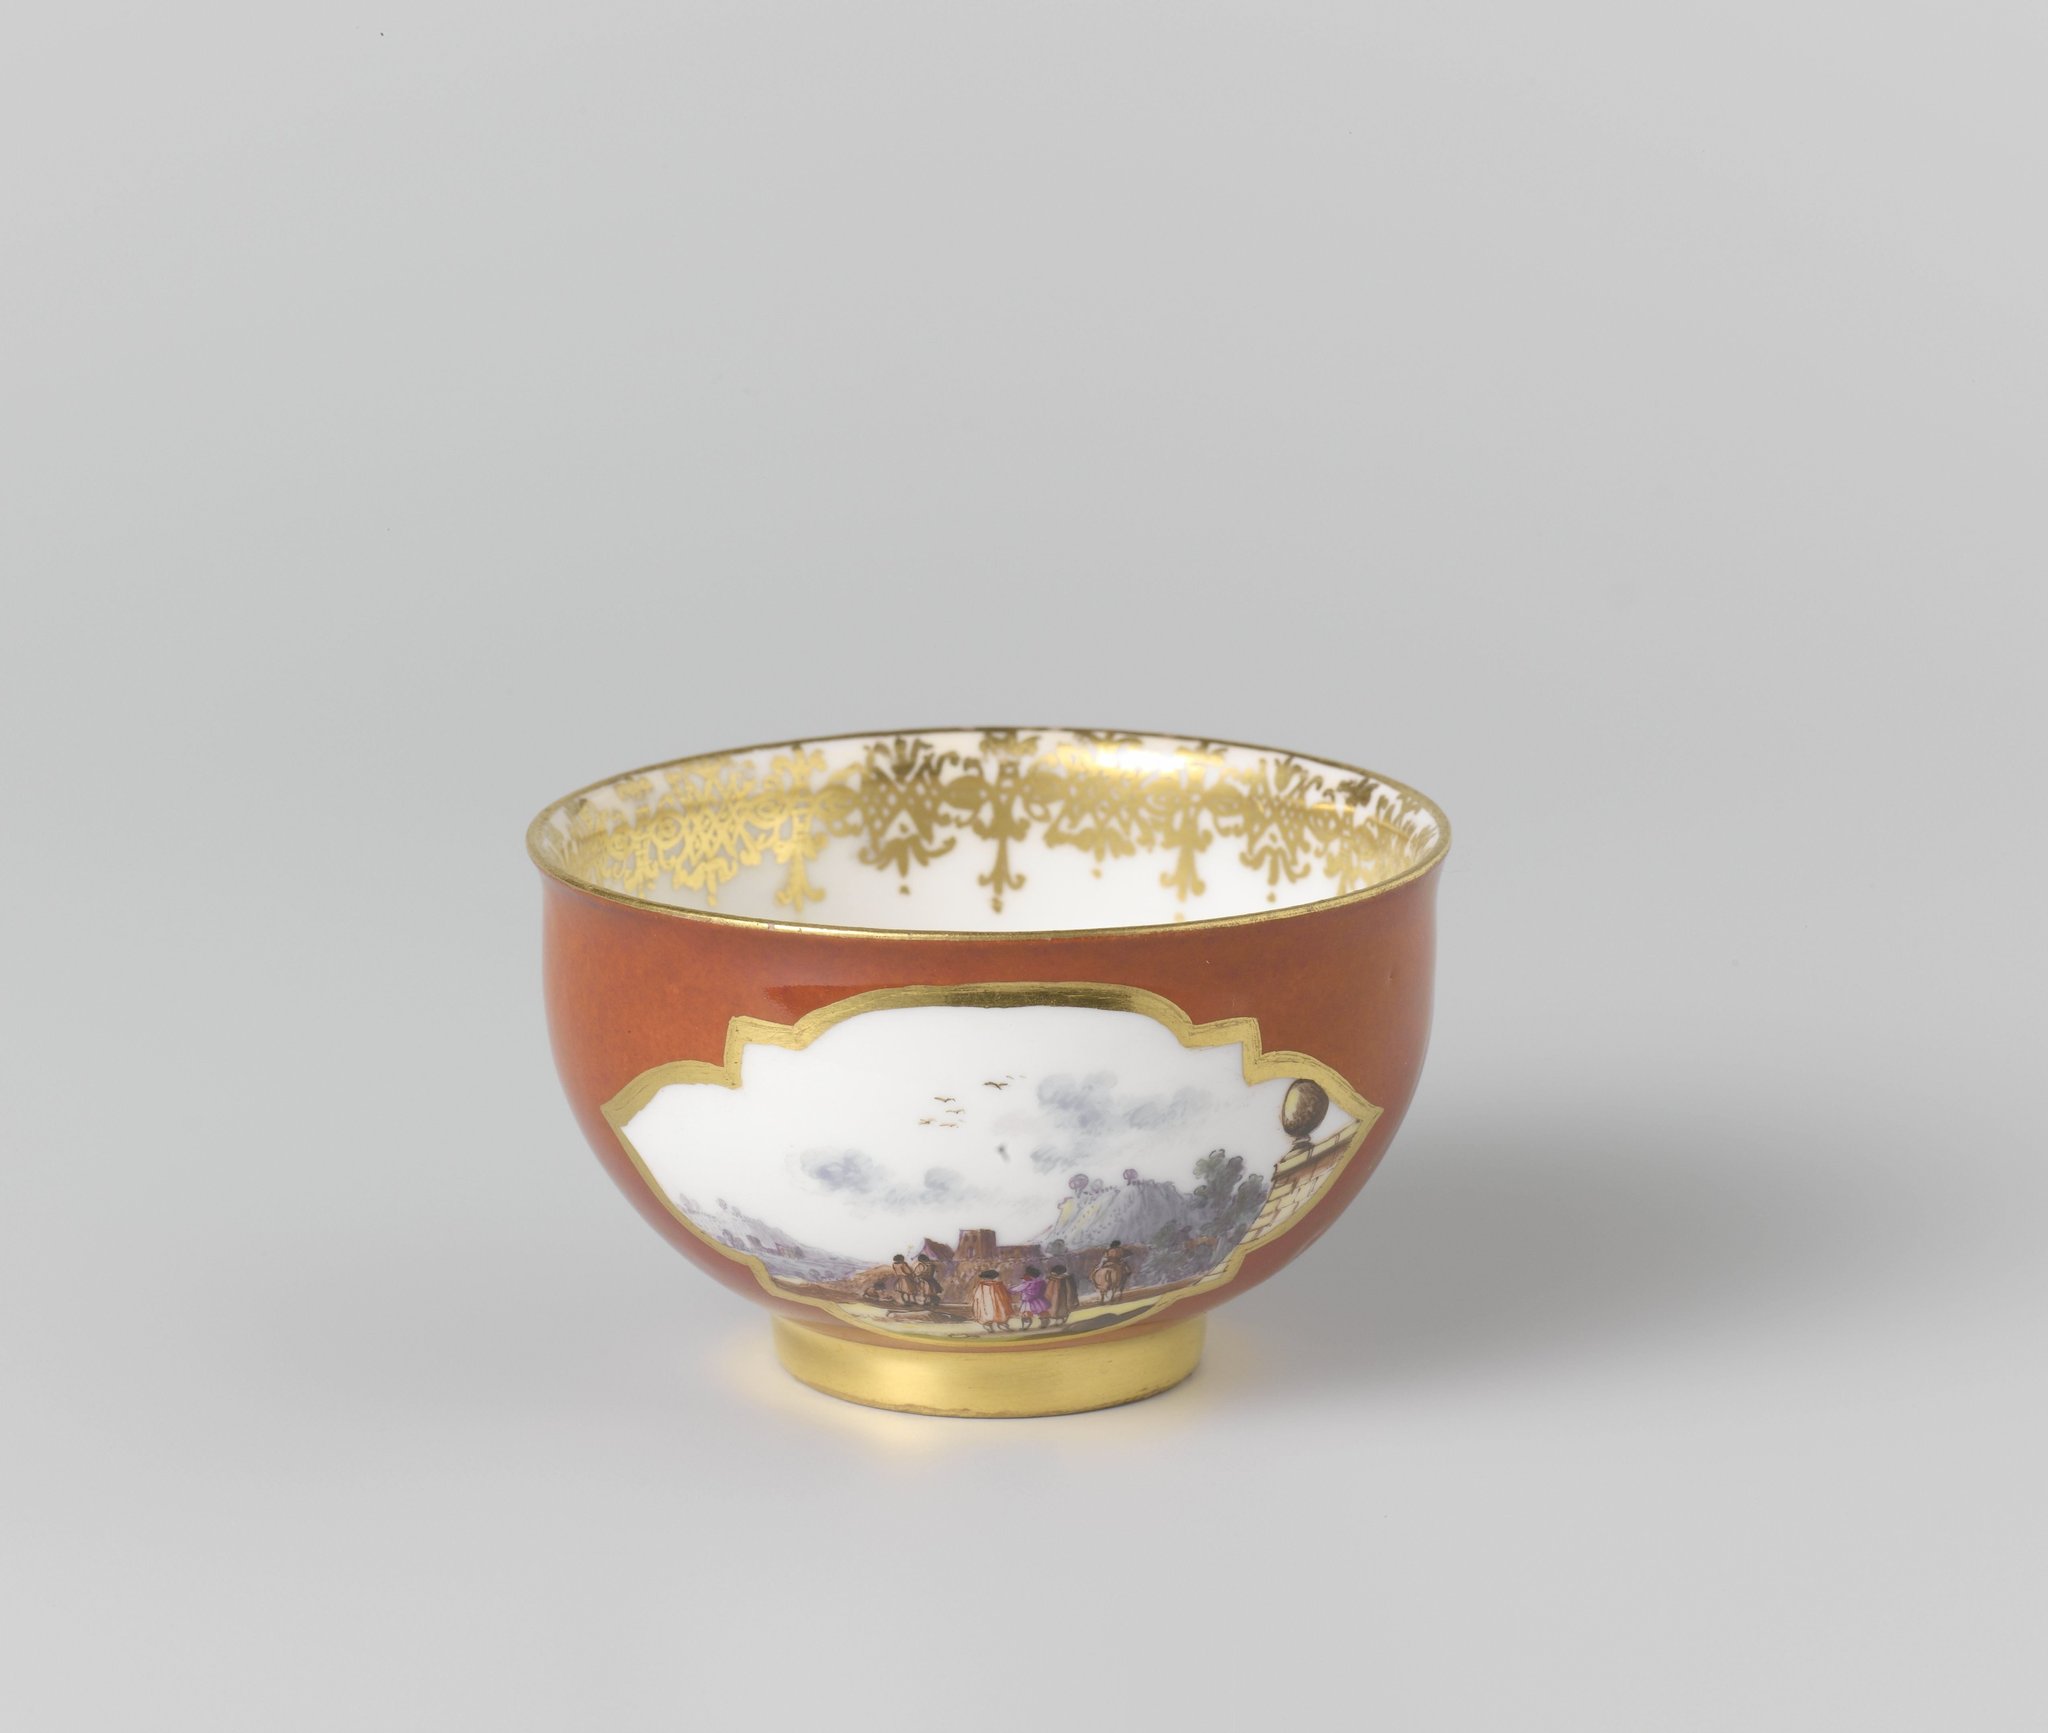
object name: cup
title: Kop, veelkleurig beschilderd met waterlandschappen in uitgespaarde vierpassen in een oranjerode fond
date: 1735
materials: porcelain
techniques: painted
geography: meissen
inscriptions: mark: ‘27’, factory mark, mold mark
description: Kop zonder oor, van beschilderd porselein. De kop is bedekt met een oranjerode fond, waarin accoladevormige vierpassen zijn uitgespaard met (water)landschappen met europese figuren, soms bij balen en schepen. De kop is gemerkt.